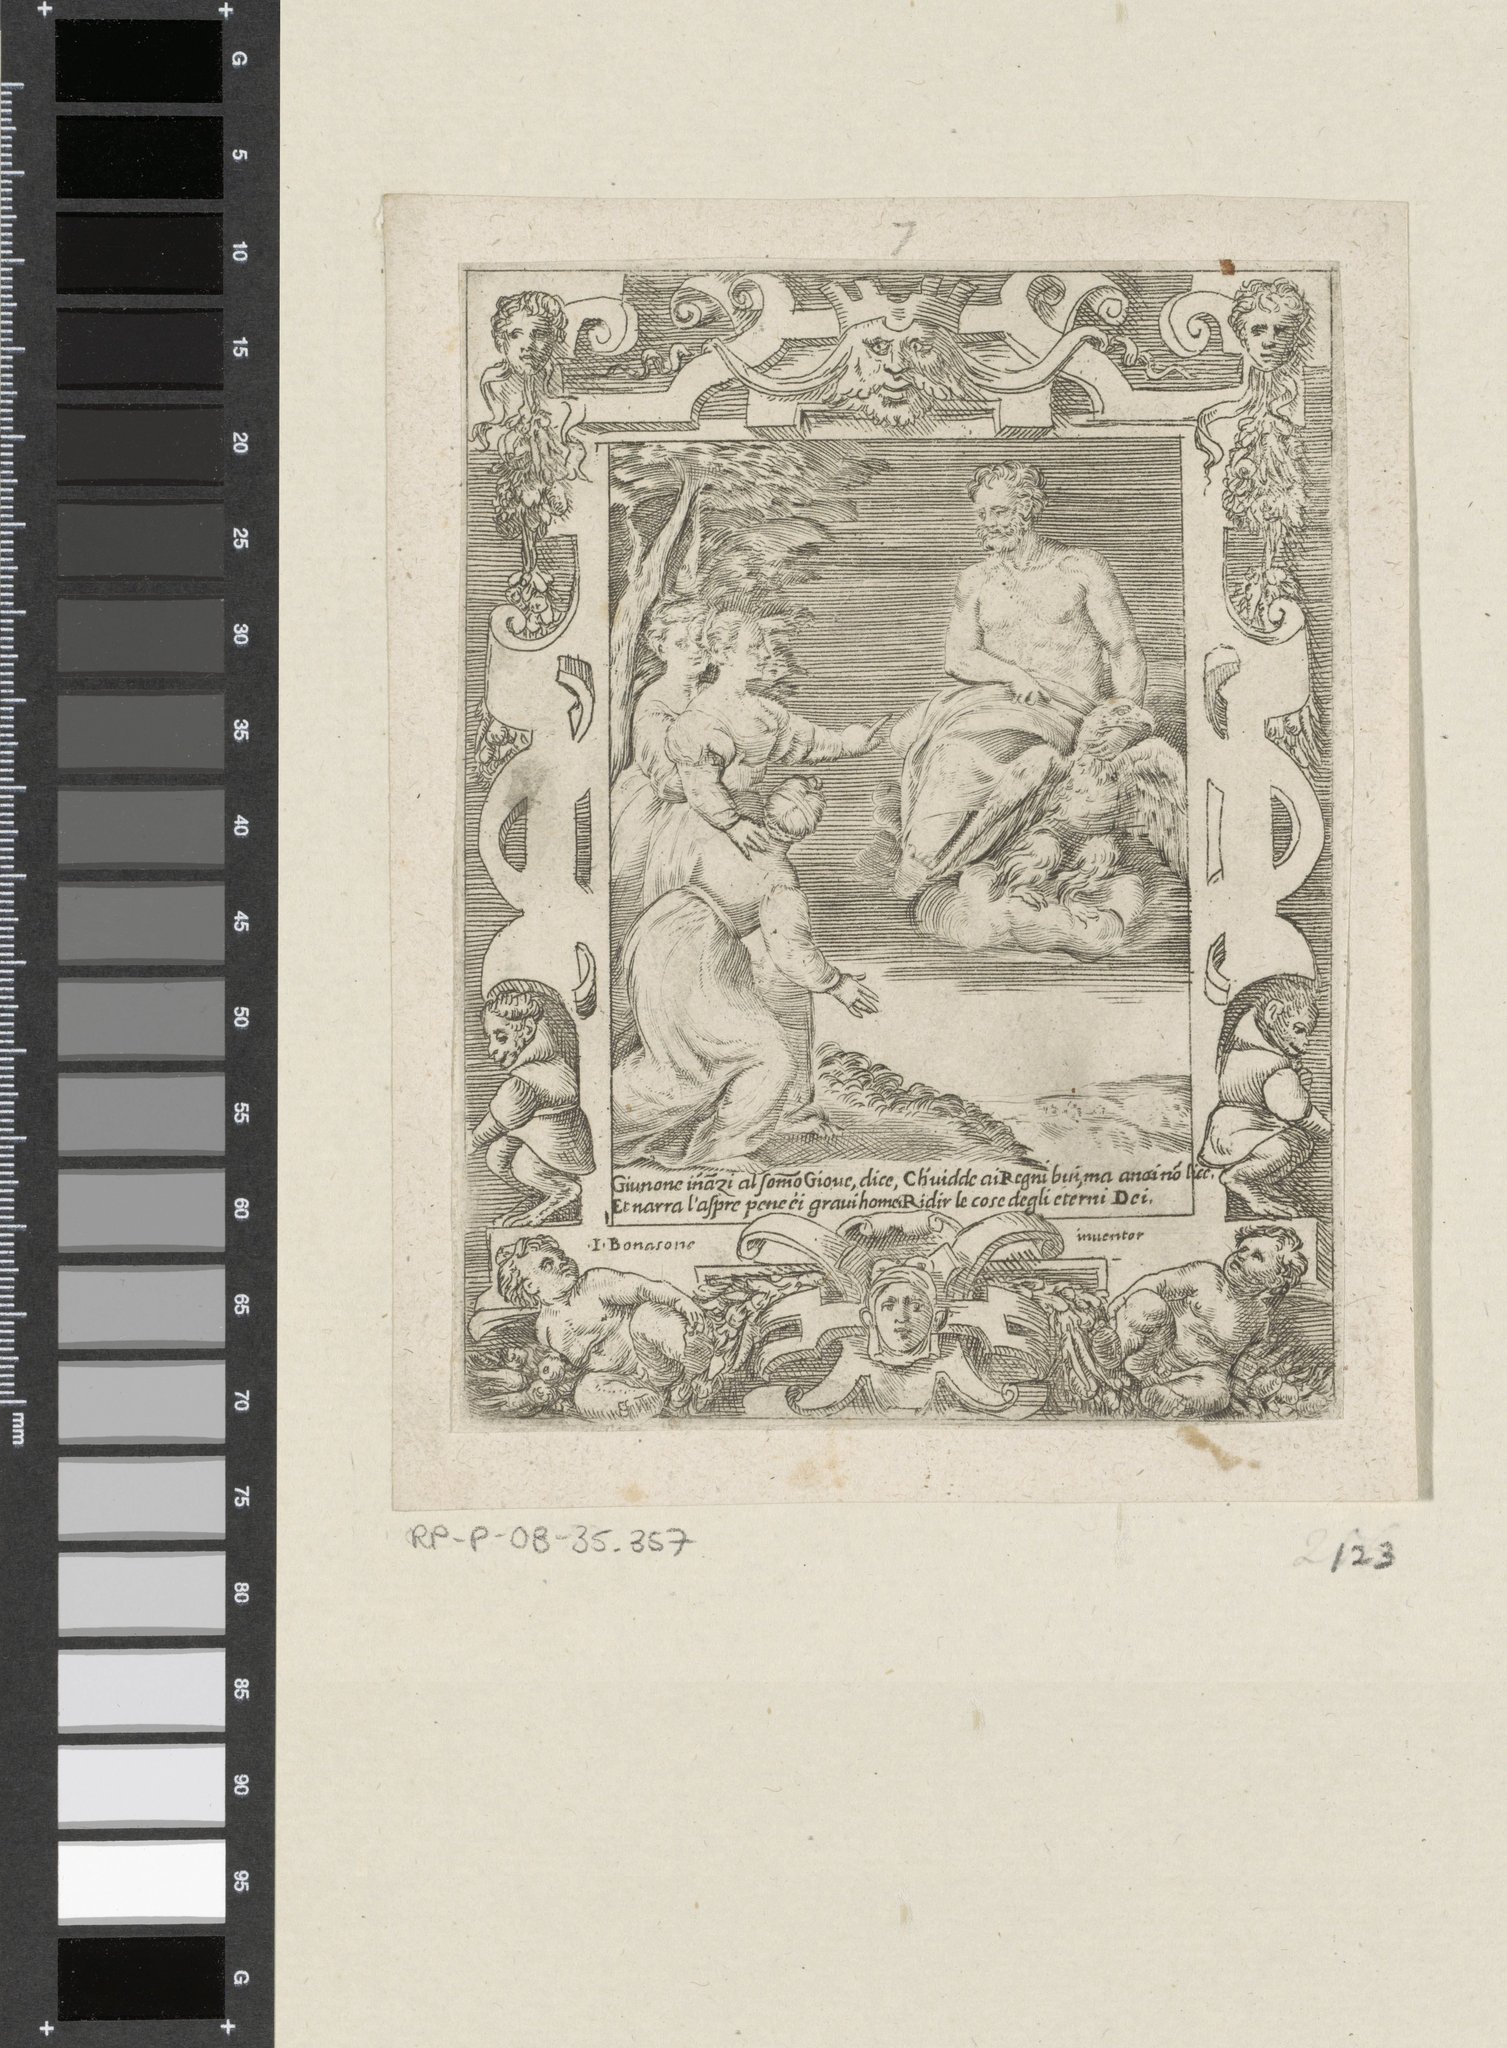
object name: print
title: Juno vraagt Jupiter de Grieken te helpen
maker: giulio bonasone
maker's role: painter, print maker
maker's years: 1510-1576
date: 1501-1580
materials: paper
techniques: engraving, etching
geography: italy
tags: jupiter as king of heaven, (story of) juno (hera)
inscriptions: collector's mark: Lugt 240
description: Jupiter zit met zijn adelaar op een wolk. Juno, bijgestaan door twee vrouwen, staat voor hem en vraagt hem de Grieken te helpen in de Trojaanse oorlog. Onder een vierregelig vers in het Italiaans. De voorstelling is gevat in een sierlijst met putti en fantasiewezens.